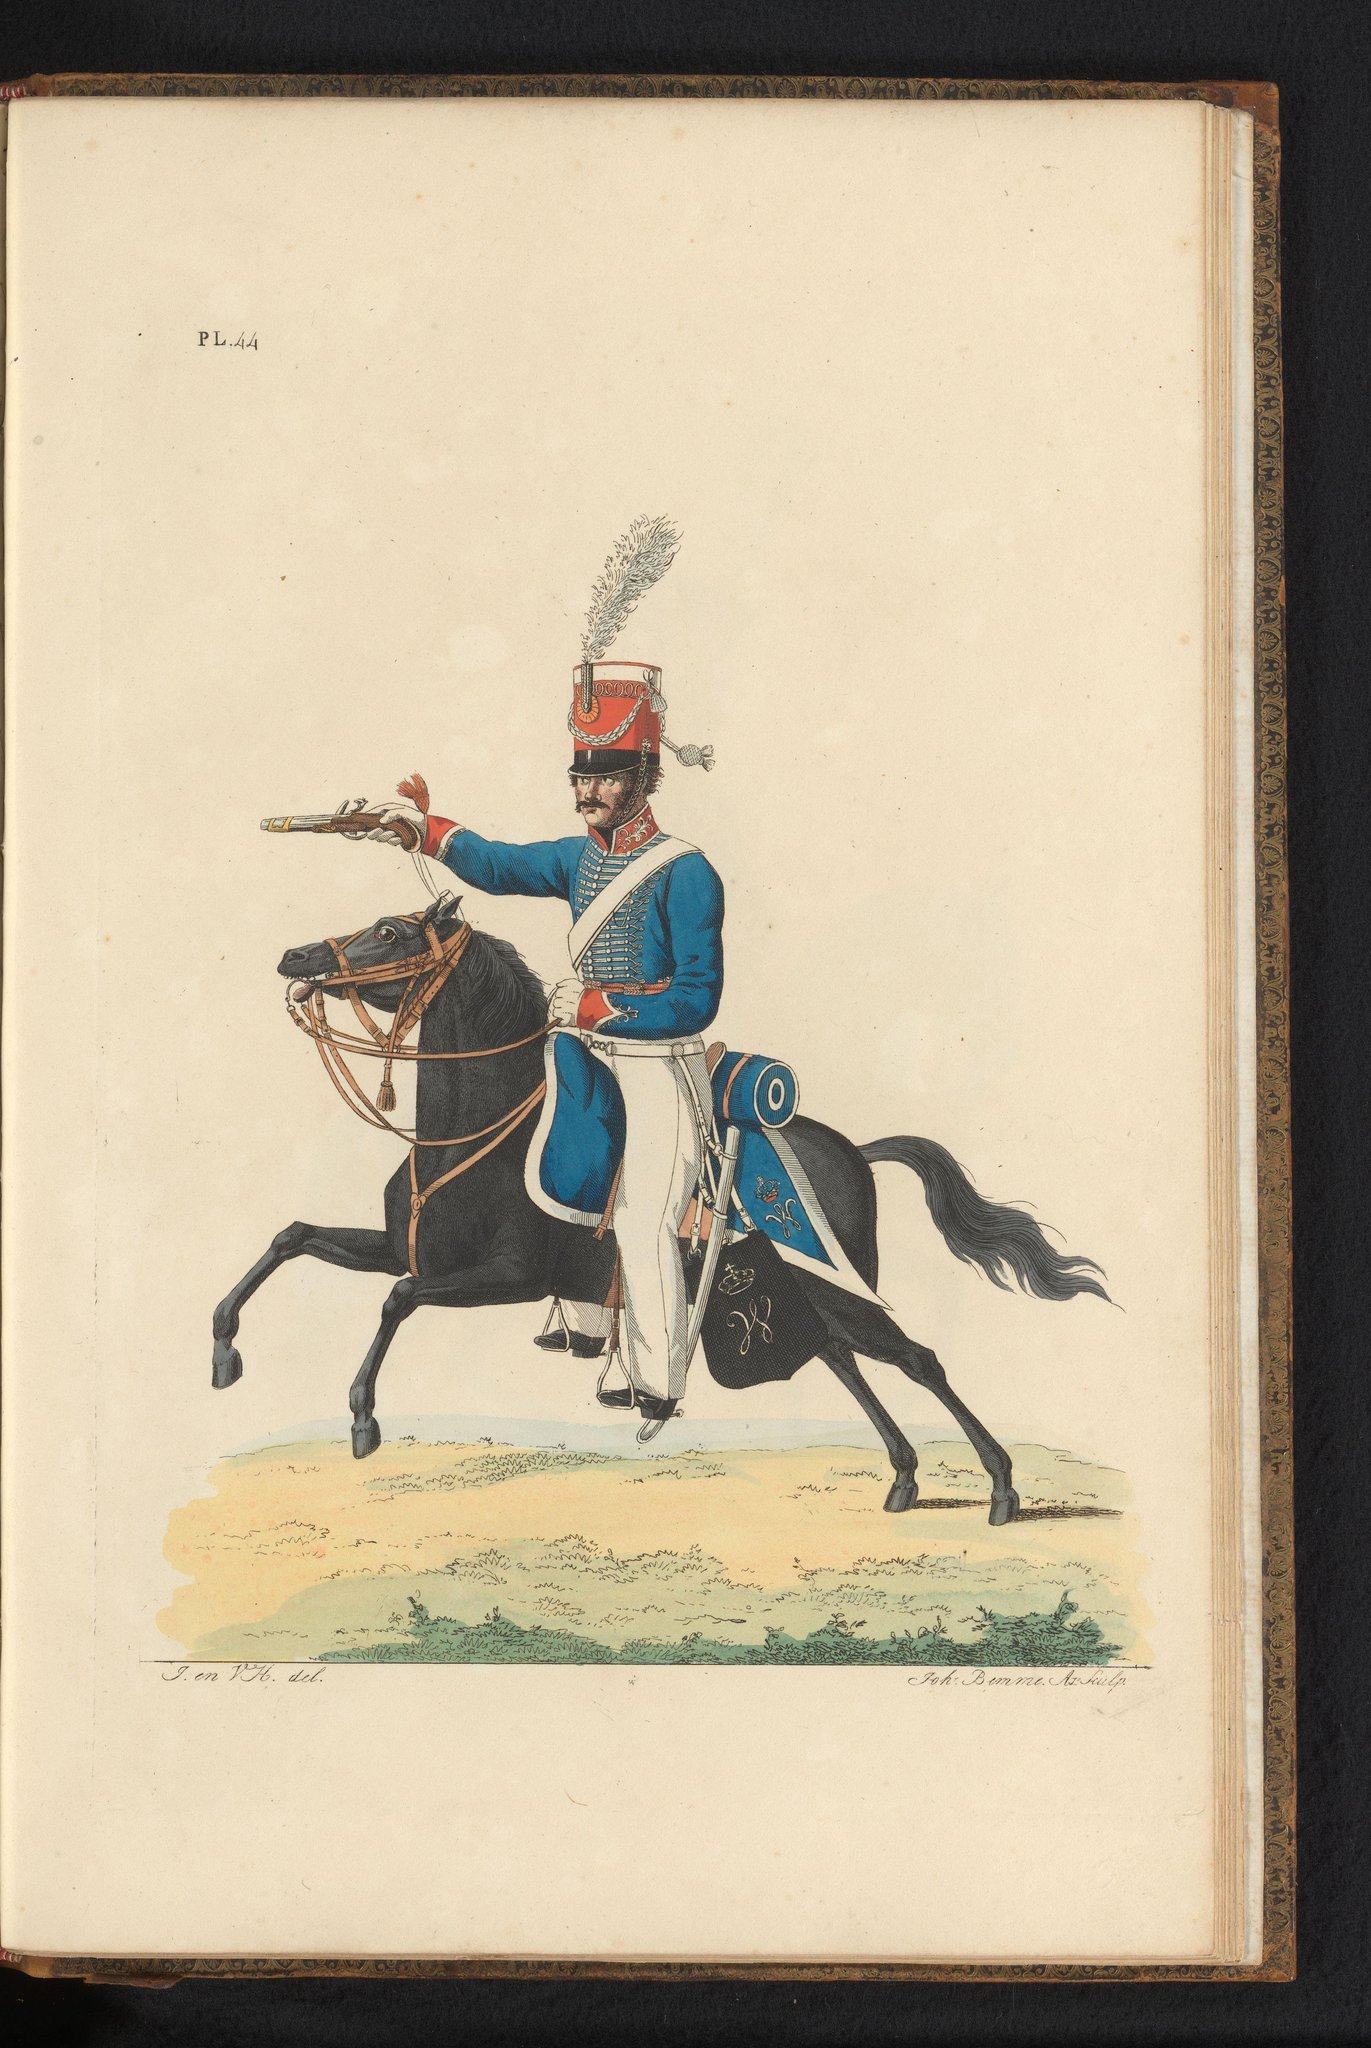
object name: print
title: Hussaar, te paard, Troepen in de Oost-Indiën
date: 1823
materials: paper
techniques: engraving, etching, hand coloring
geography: netherlands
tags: (military) uniforms, dutch east indies, the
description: Een huzaar van het Regiment Huzaren Nr. 7, Nederlandse troepen in Oost-Indië. Plaat 44. Uniformvoorstelling in 'Beschrijving hoedanig de Koninklijke Nederlandsche troepen' van J.F. Teupken, 1823.